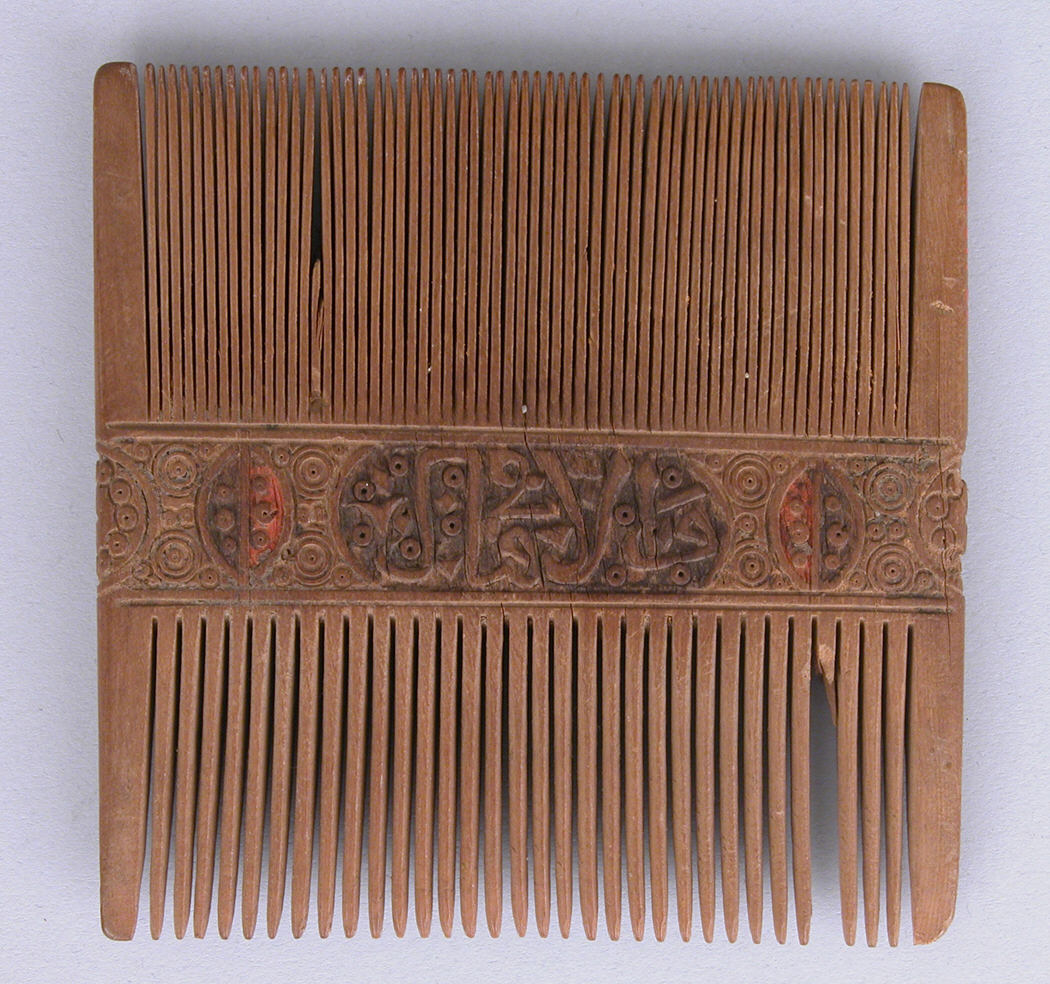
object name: comb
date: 1201-1300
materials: wood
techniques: carving, painting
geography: egypt